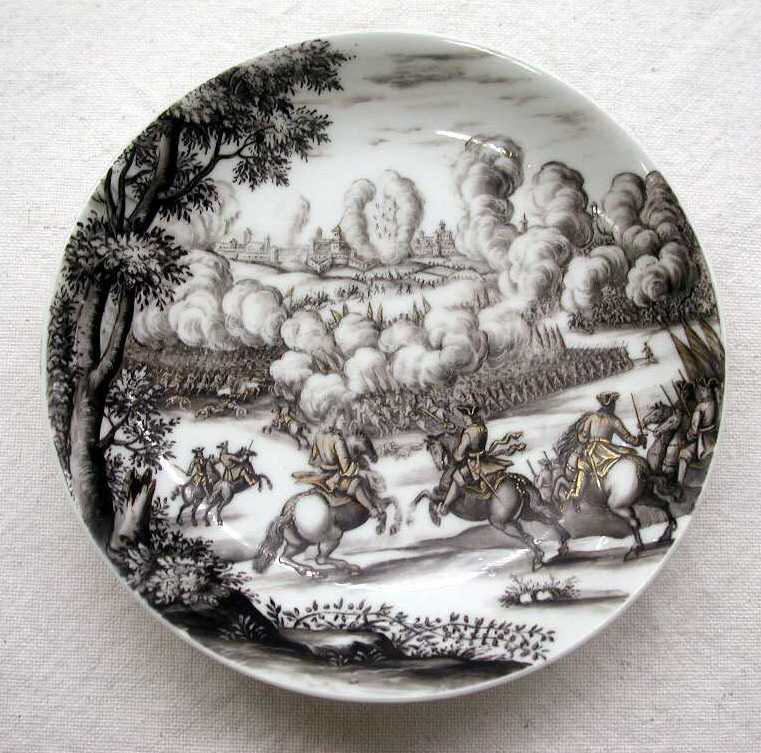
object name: saucer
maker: meissen manufactory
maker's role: manufactory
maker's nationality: german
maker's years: 1710-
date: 1720-1725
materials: hard paste porcelain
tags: battles,men,horses,trees